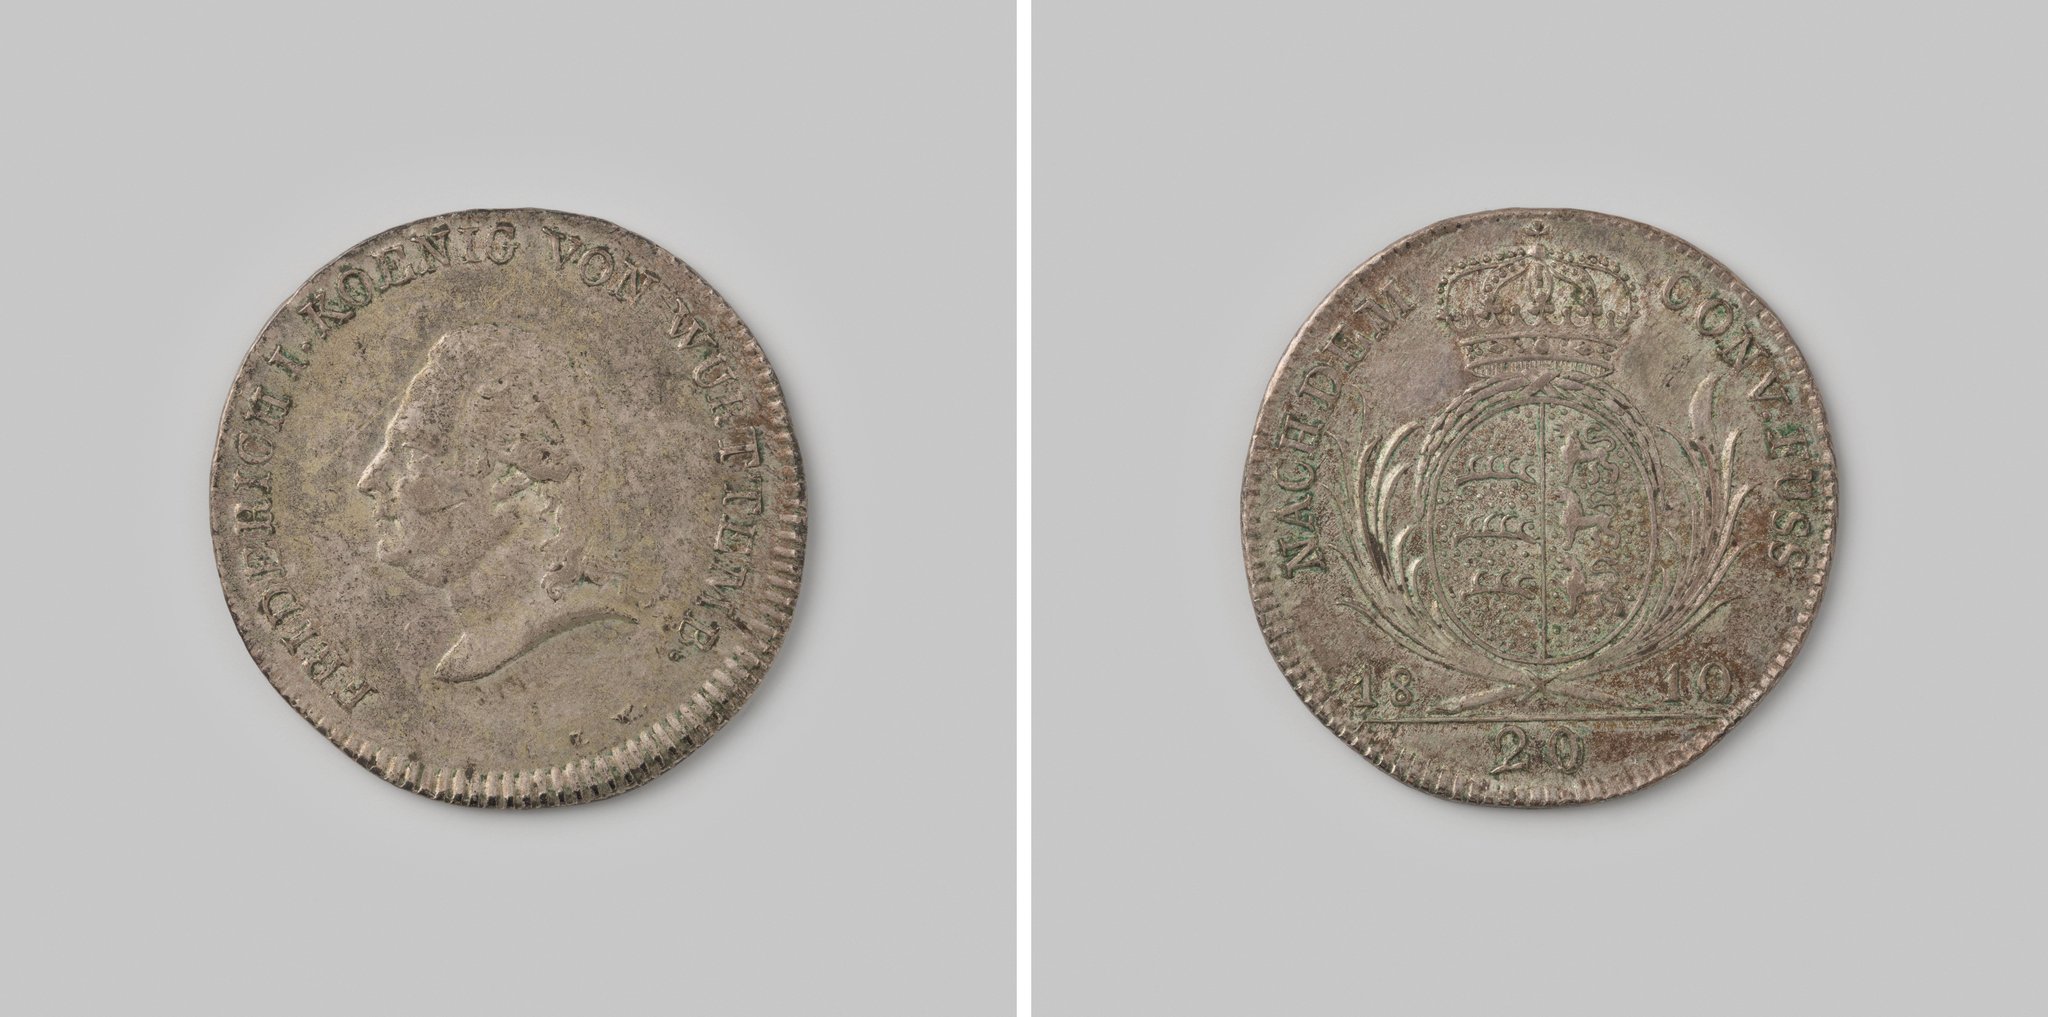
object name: coin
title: 20 Kreuzer uit het koninkrijk Wurtemberg van Friedrich I, 1810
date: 1810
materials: silver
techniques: striking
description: Zilveren munt. Voorzijde: hoofd van de koning naar links. Keerzijde: tussen jaartal binnen twee samengebonden palmtakken gekroond versierd samengesteld wapenschild. In afsnede waarde-aanduiding. Kabelrand.